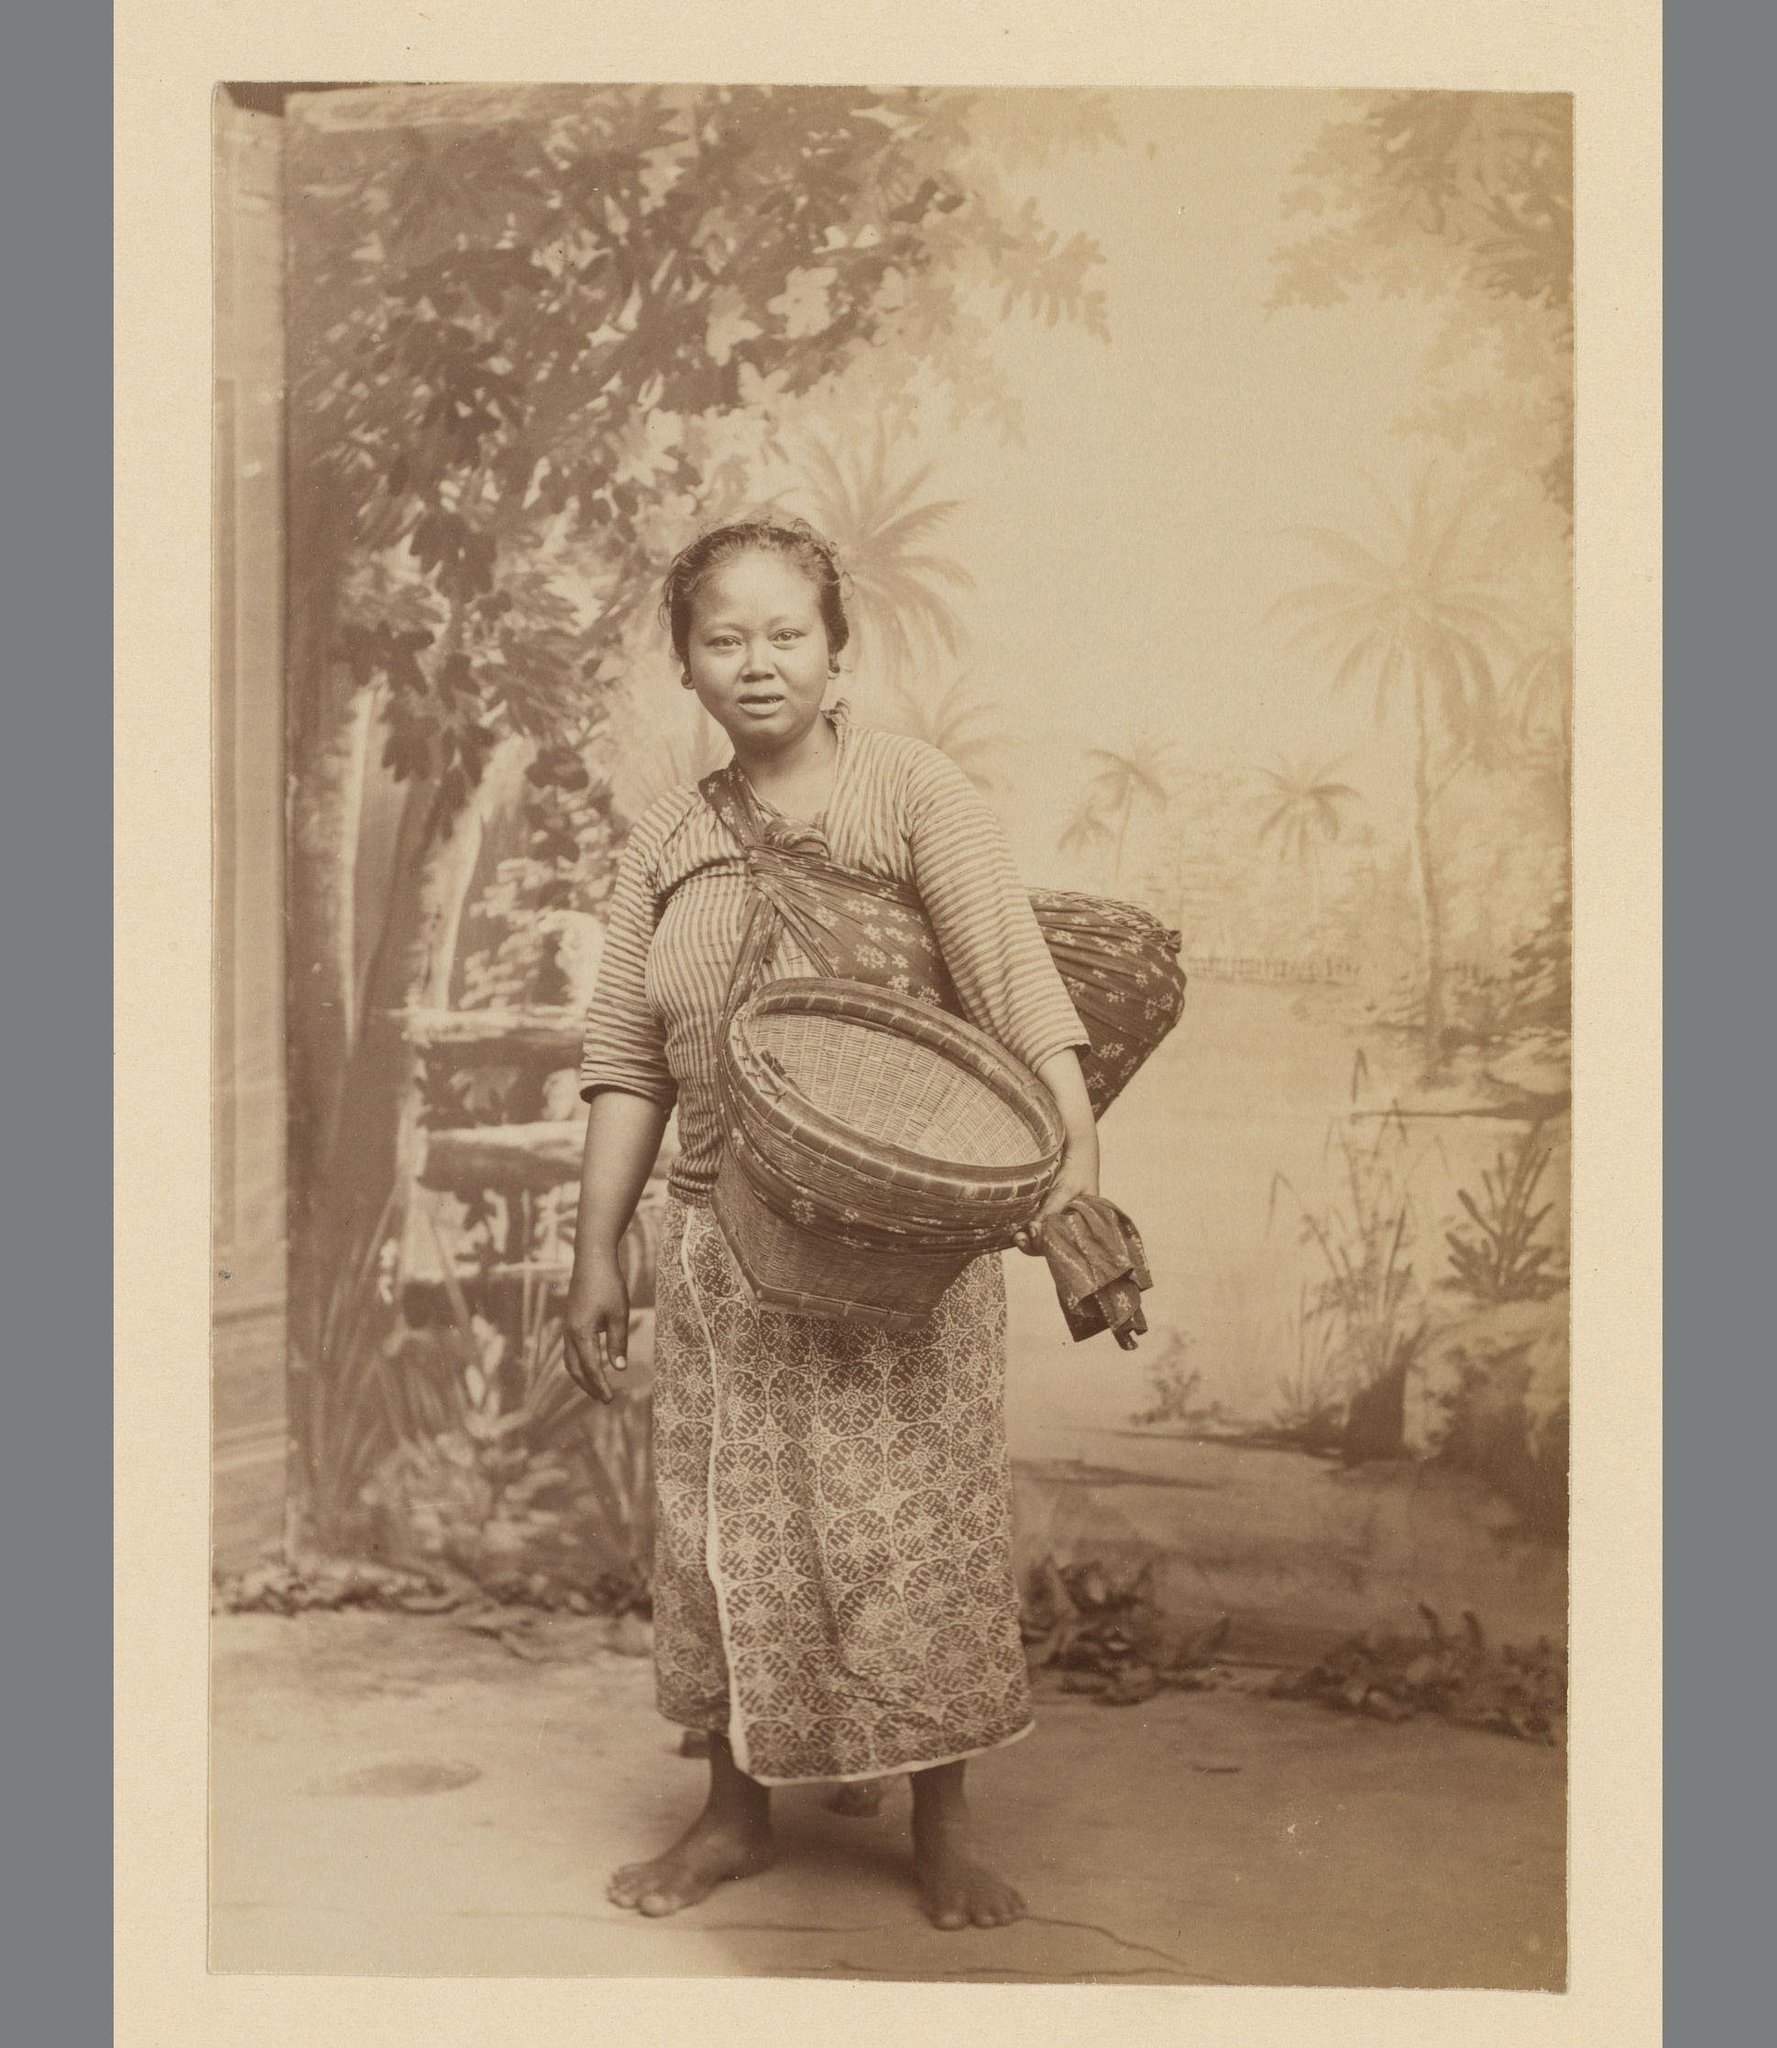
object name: photograph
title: Koopvrouw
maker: Anonymous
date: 1851-1900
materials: cardboard, paper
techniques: albumen print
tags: historical persons - bb - woman, merchant, salesman - bb - women engaged in trade and commerce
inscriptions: inscription: ‘FOTO’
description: Deze foto zat oorspronkelijk in prentenkabinet RP-F-AA3192.